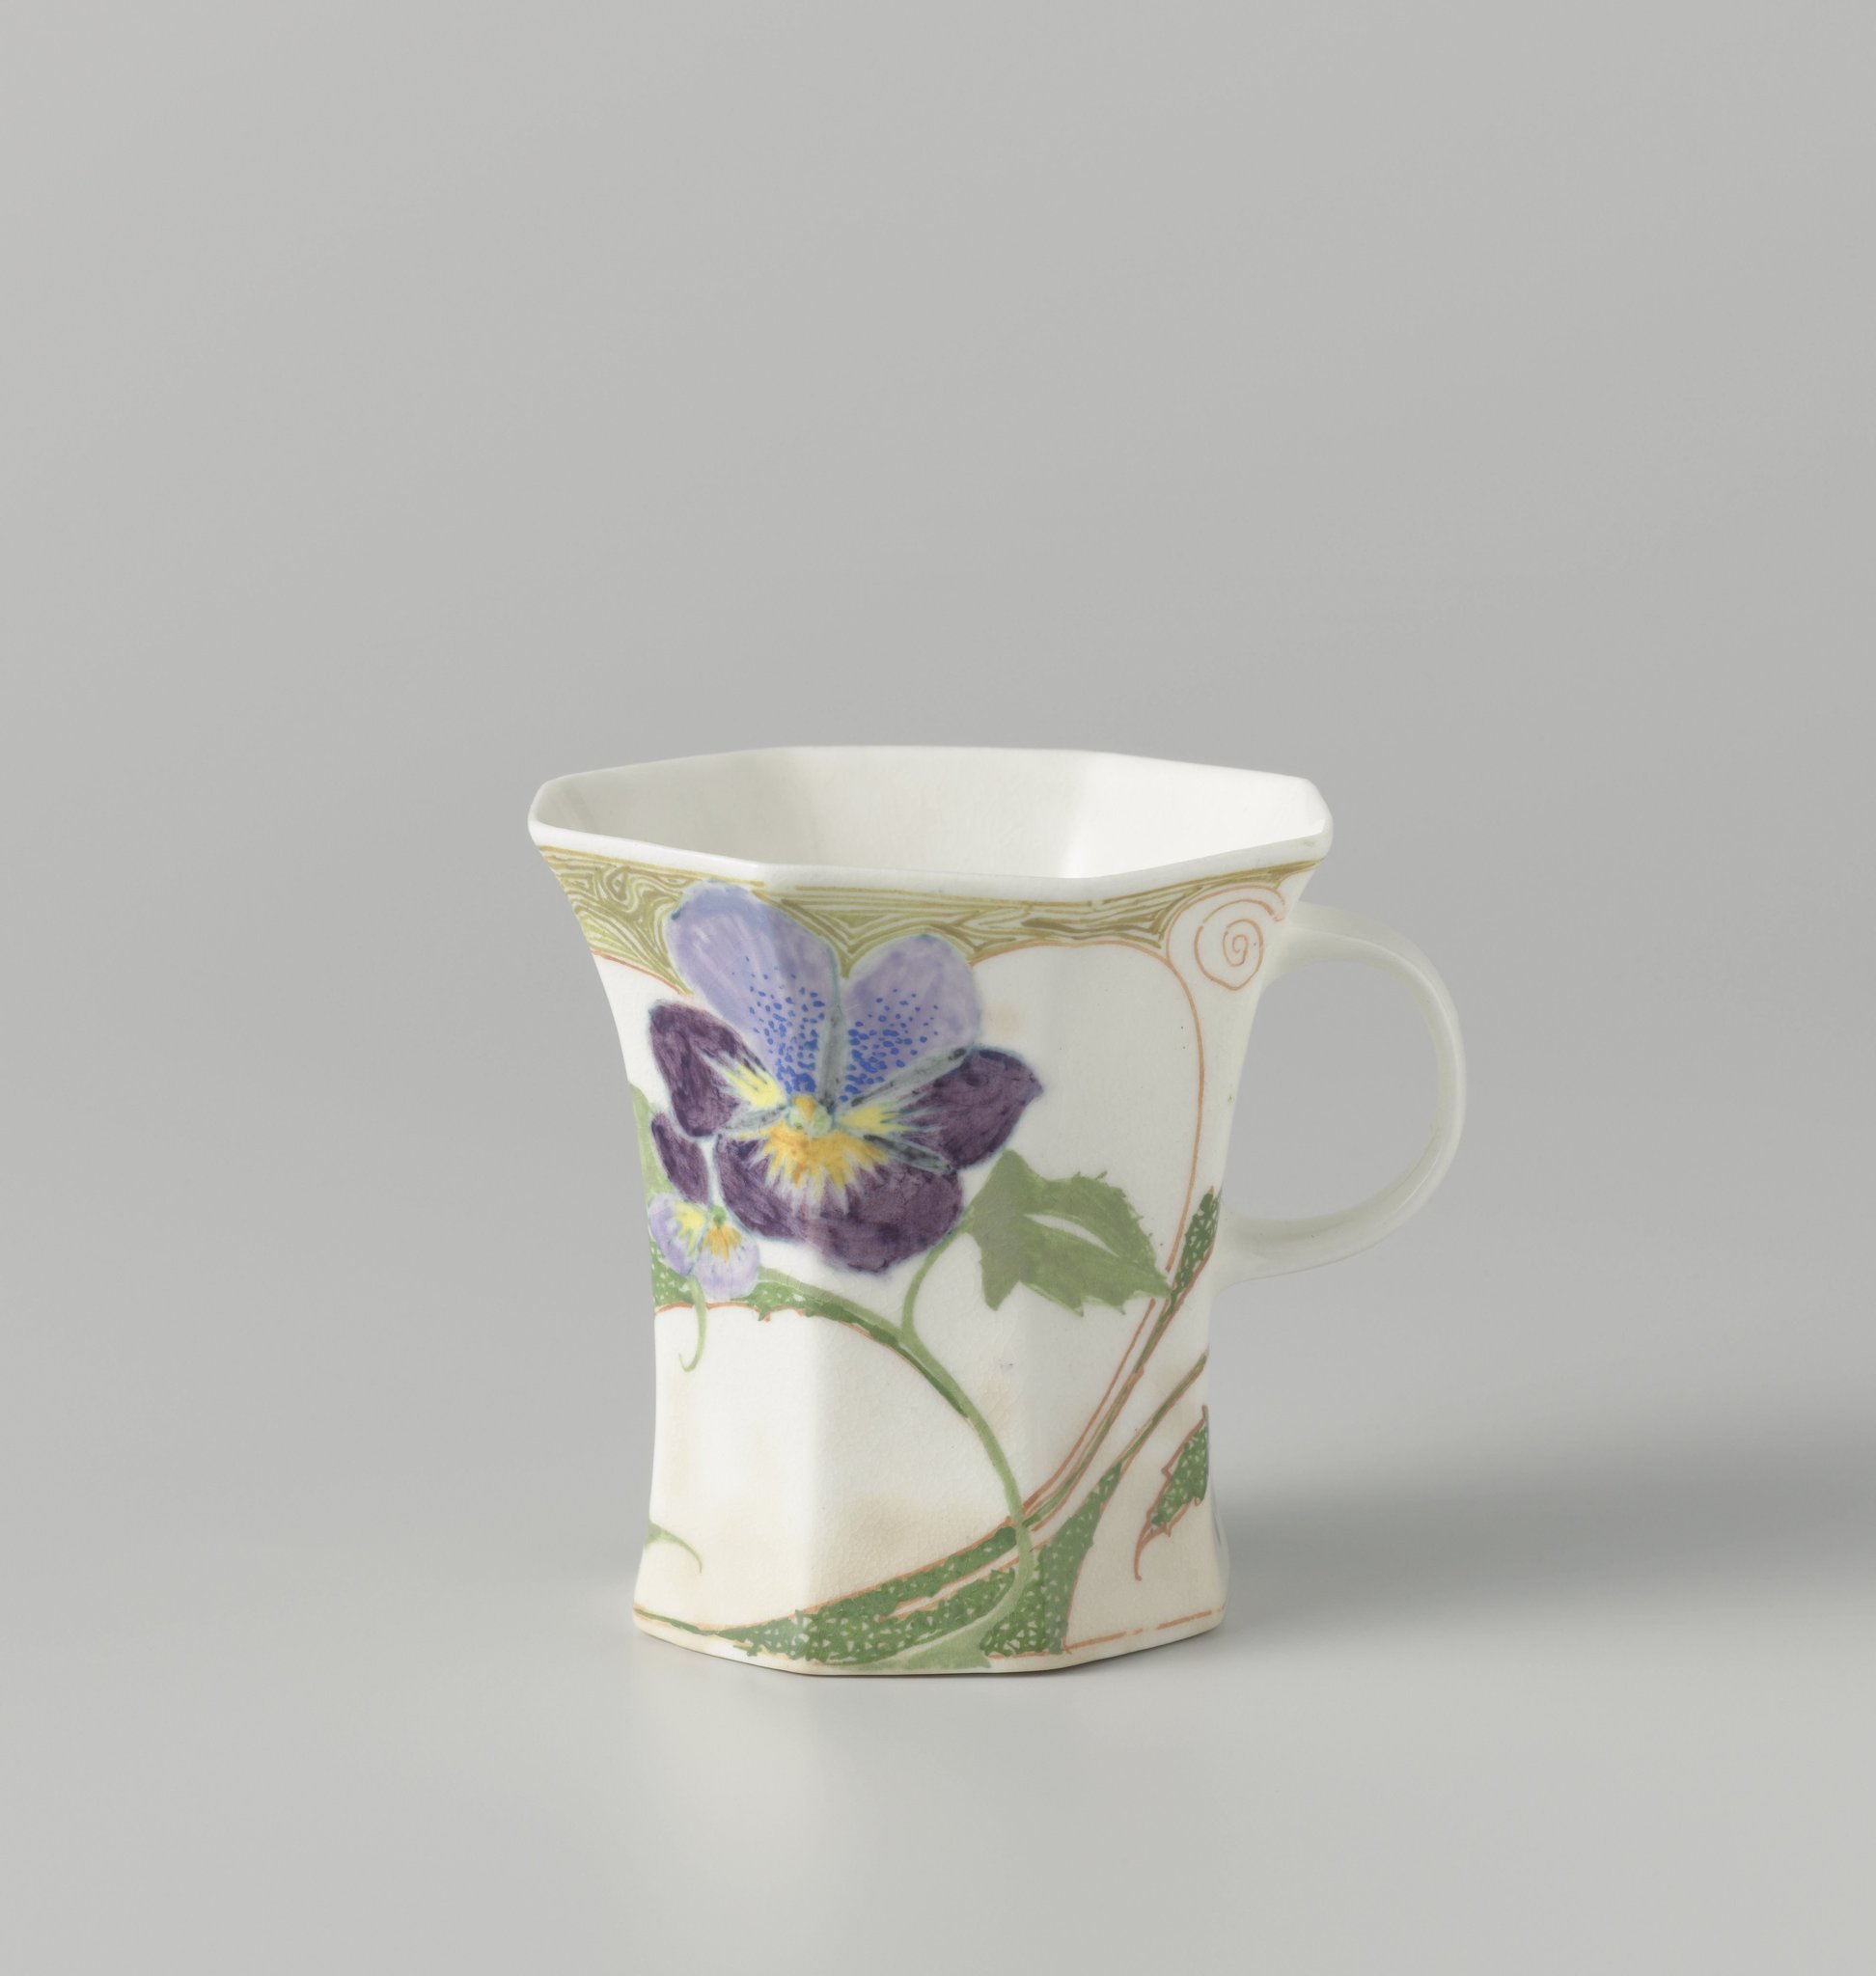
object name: cup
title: Kop, deel van een servies, beschilderd met violen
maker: c.w.j. t hart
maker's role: plateelschilder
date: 1913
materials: porcelain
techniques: painted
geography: the hague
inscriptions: mark: ‘kroon, Rozenburg, ooievaar, den Haag (boven elkaar); links het merk voor 1913, rechts het werkordernummer 332 (op een kop 333); onder het schildersmerk van C.W.J. 't Hart.’